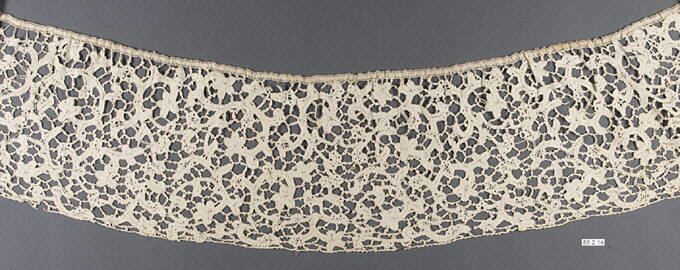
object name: fragment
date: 1667-1700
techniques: lace